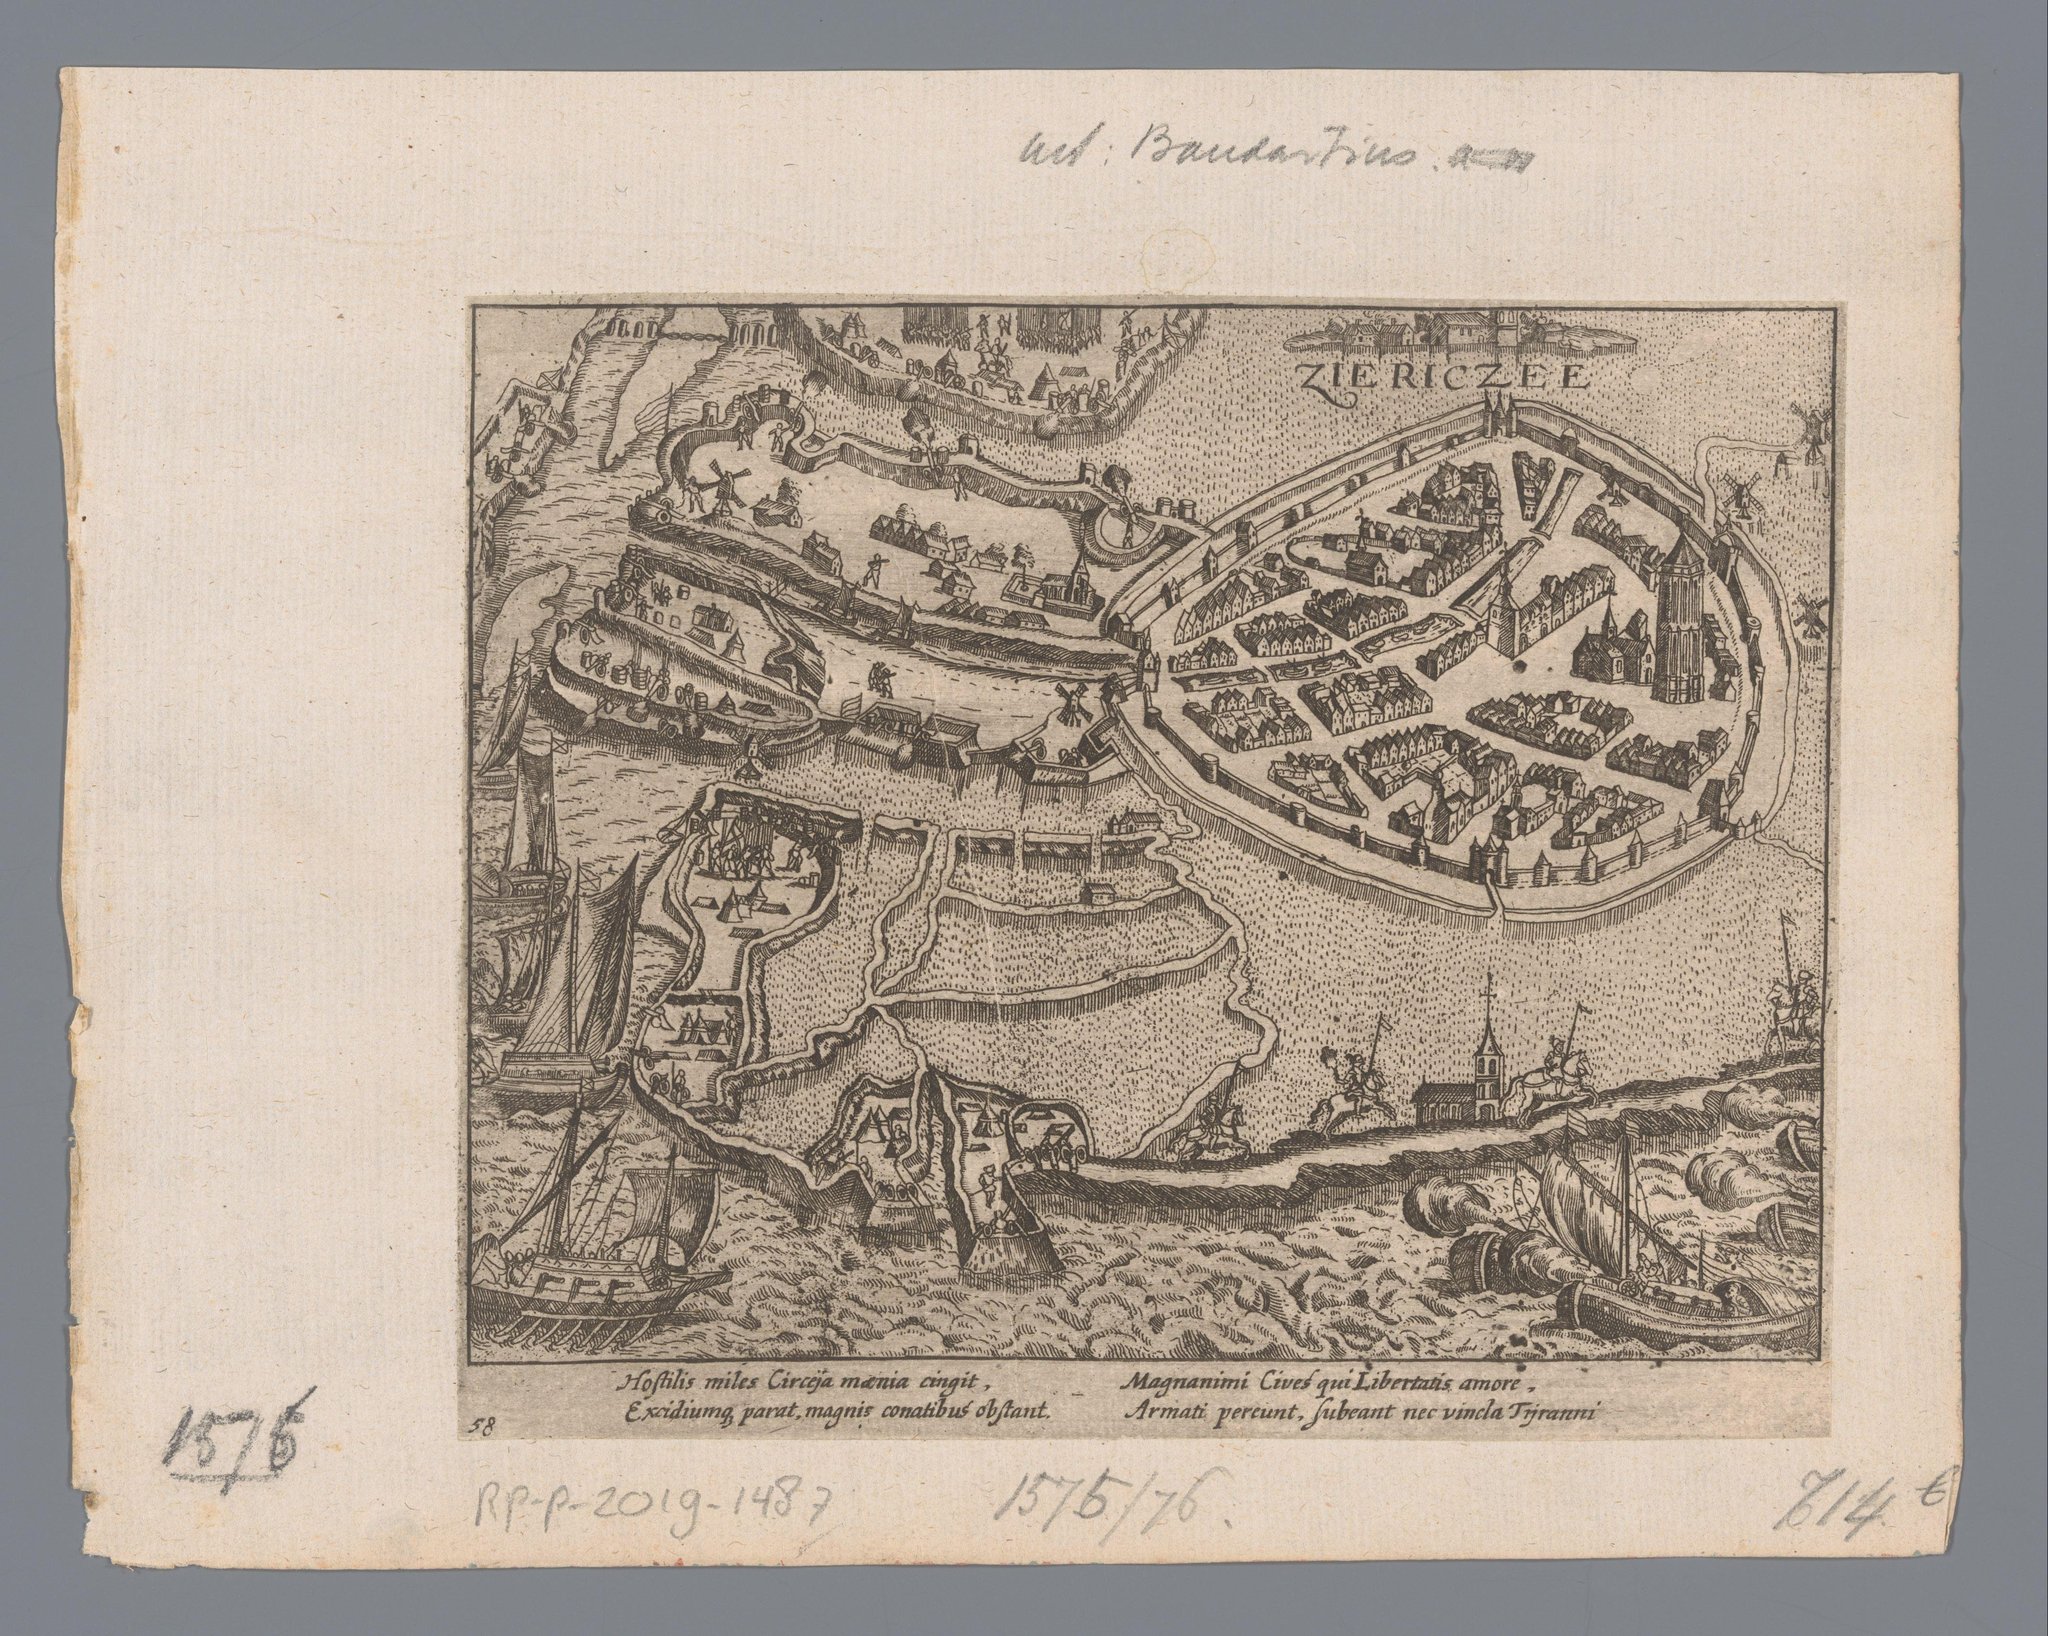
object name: print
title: Ziericzee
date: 1616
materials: paper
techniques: etching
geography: northern netherlands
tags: antwerp, attack ~ siege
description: Beleg van Zierikzee door de Spanjaarden onder Mondragon. Ondanks een geslaagde poging van de schepen van de prins om de stad van proviand te voorzien geeft de stad zich over op 29 juni 1576. Gezicht op de ommuurde stad met de posities van de belegerende Spaanse troepen en de Spaanse schepen en de schepen van de prins. Met onderschrift van vier regels in het Latijn. Linksonder genummerd: 58.